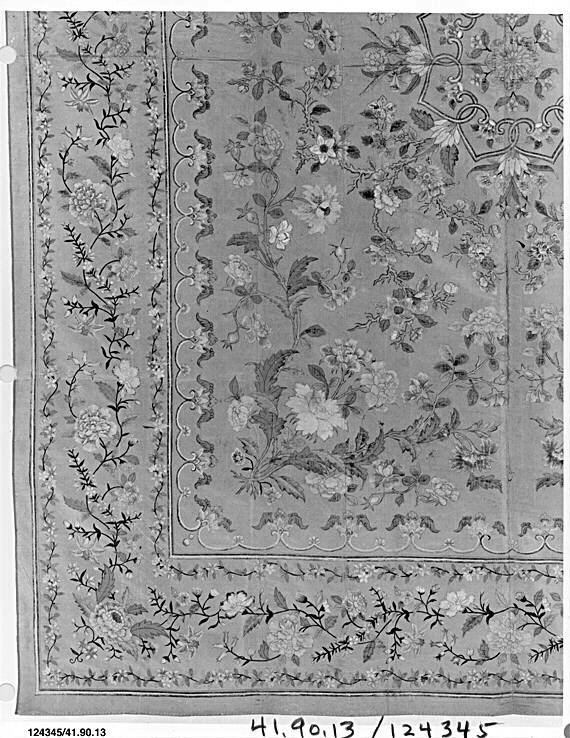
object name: bed cover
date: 1801-1900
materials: silk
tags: flowers